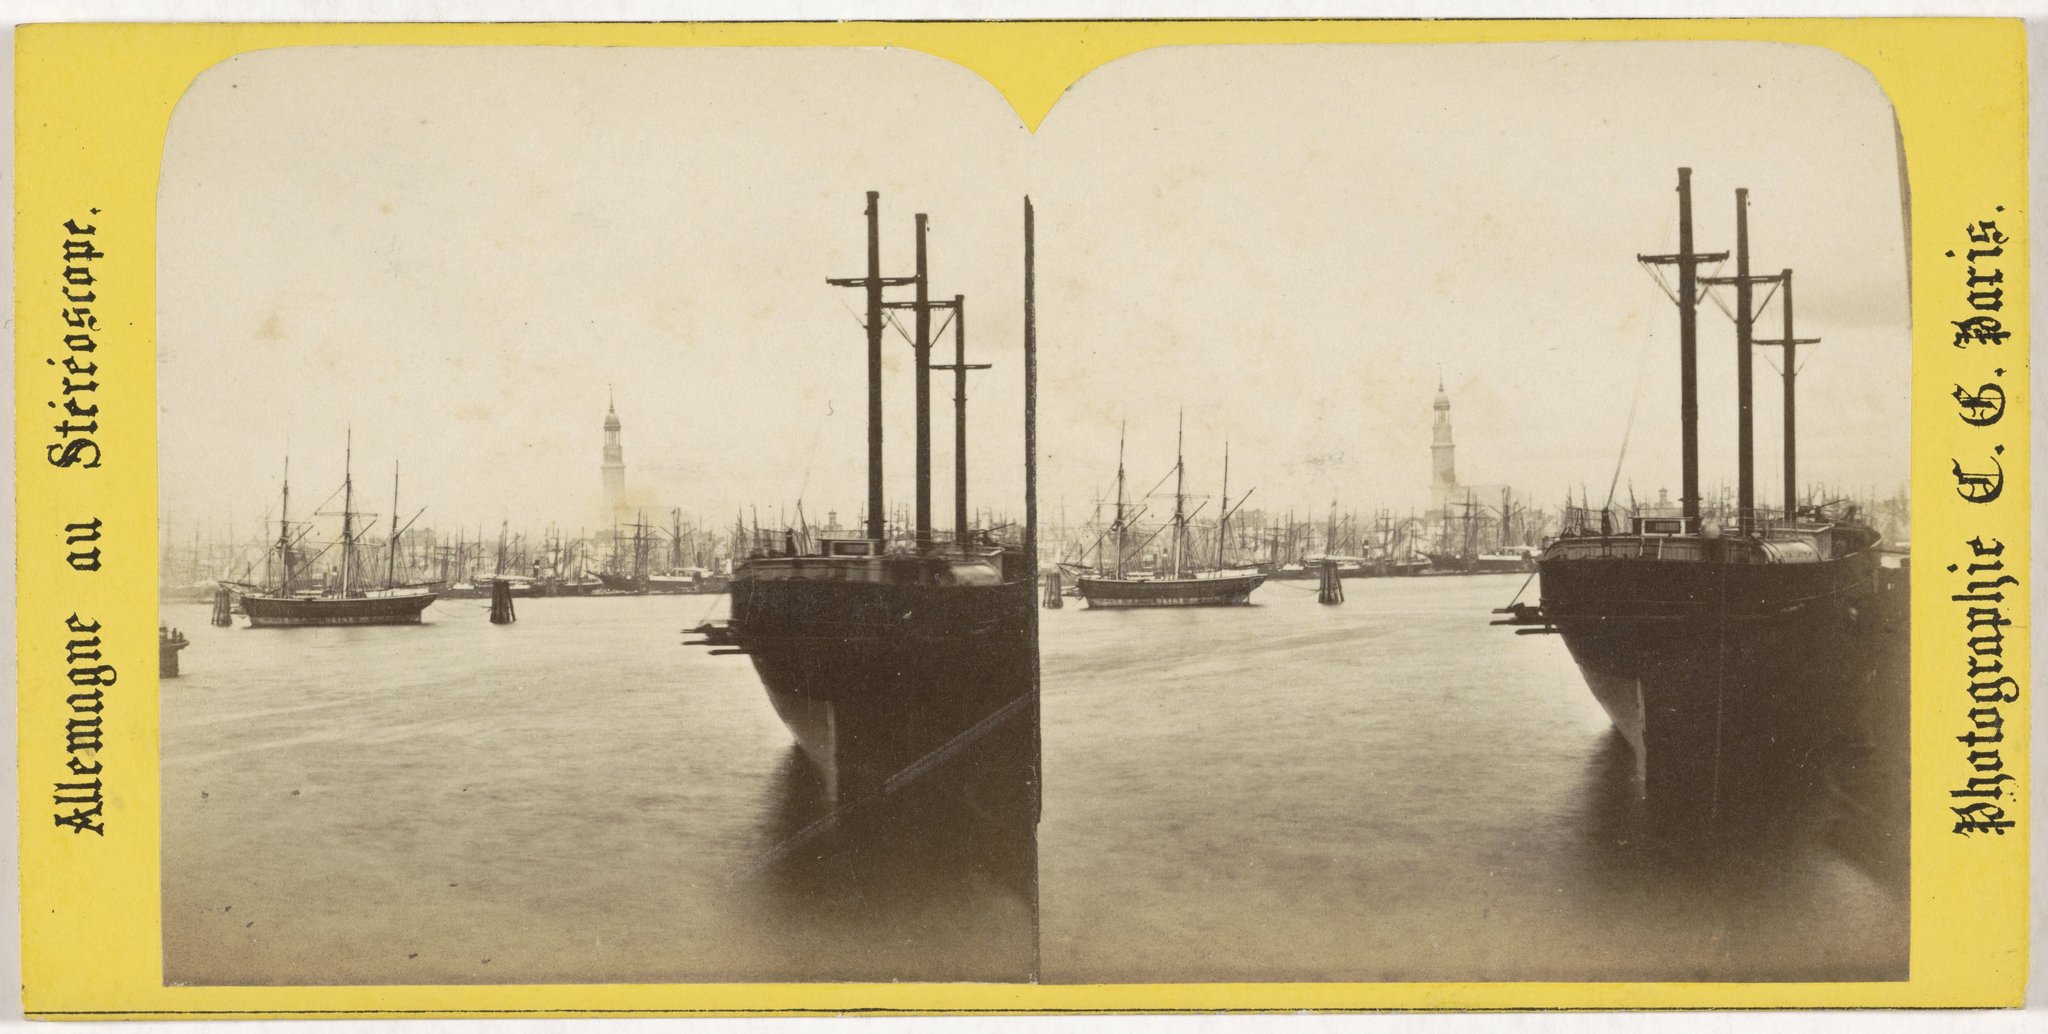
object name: stereograph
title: Allemagne au stéréoscope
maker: charles gaudin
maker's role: publisher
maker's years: 1825-1905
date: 1860-1870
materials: cardboard, paper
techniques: albumen print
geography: hamburg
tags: harbour, ships (in general) - cc - more than one ship, prospect of city, town panorama, silhouette of city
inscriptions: number: ‘329’, number: ‘329.’